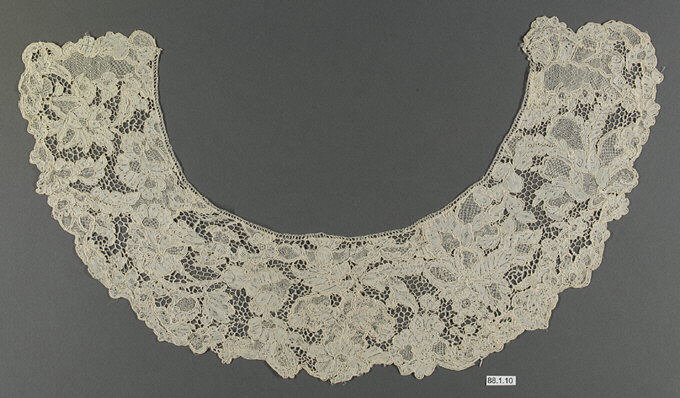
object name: collar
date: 1701-1733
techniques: lace